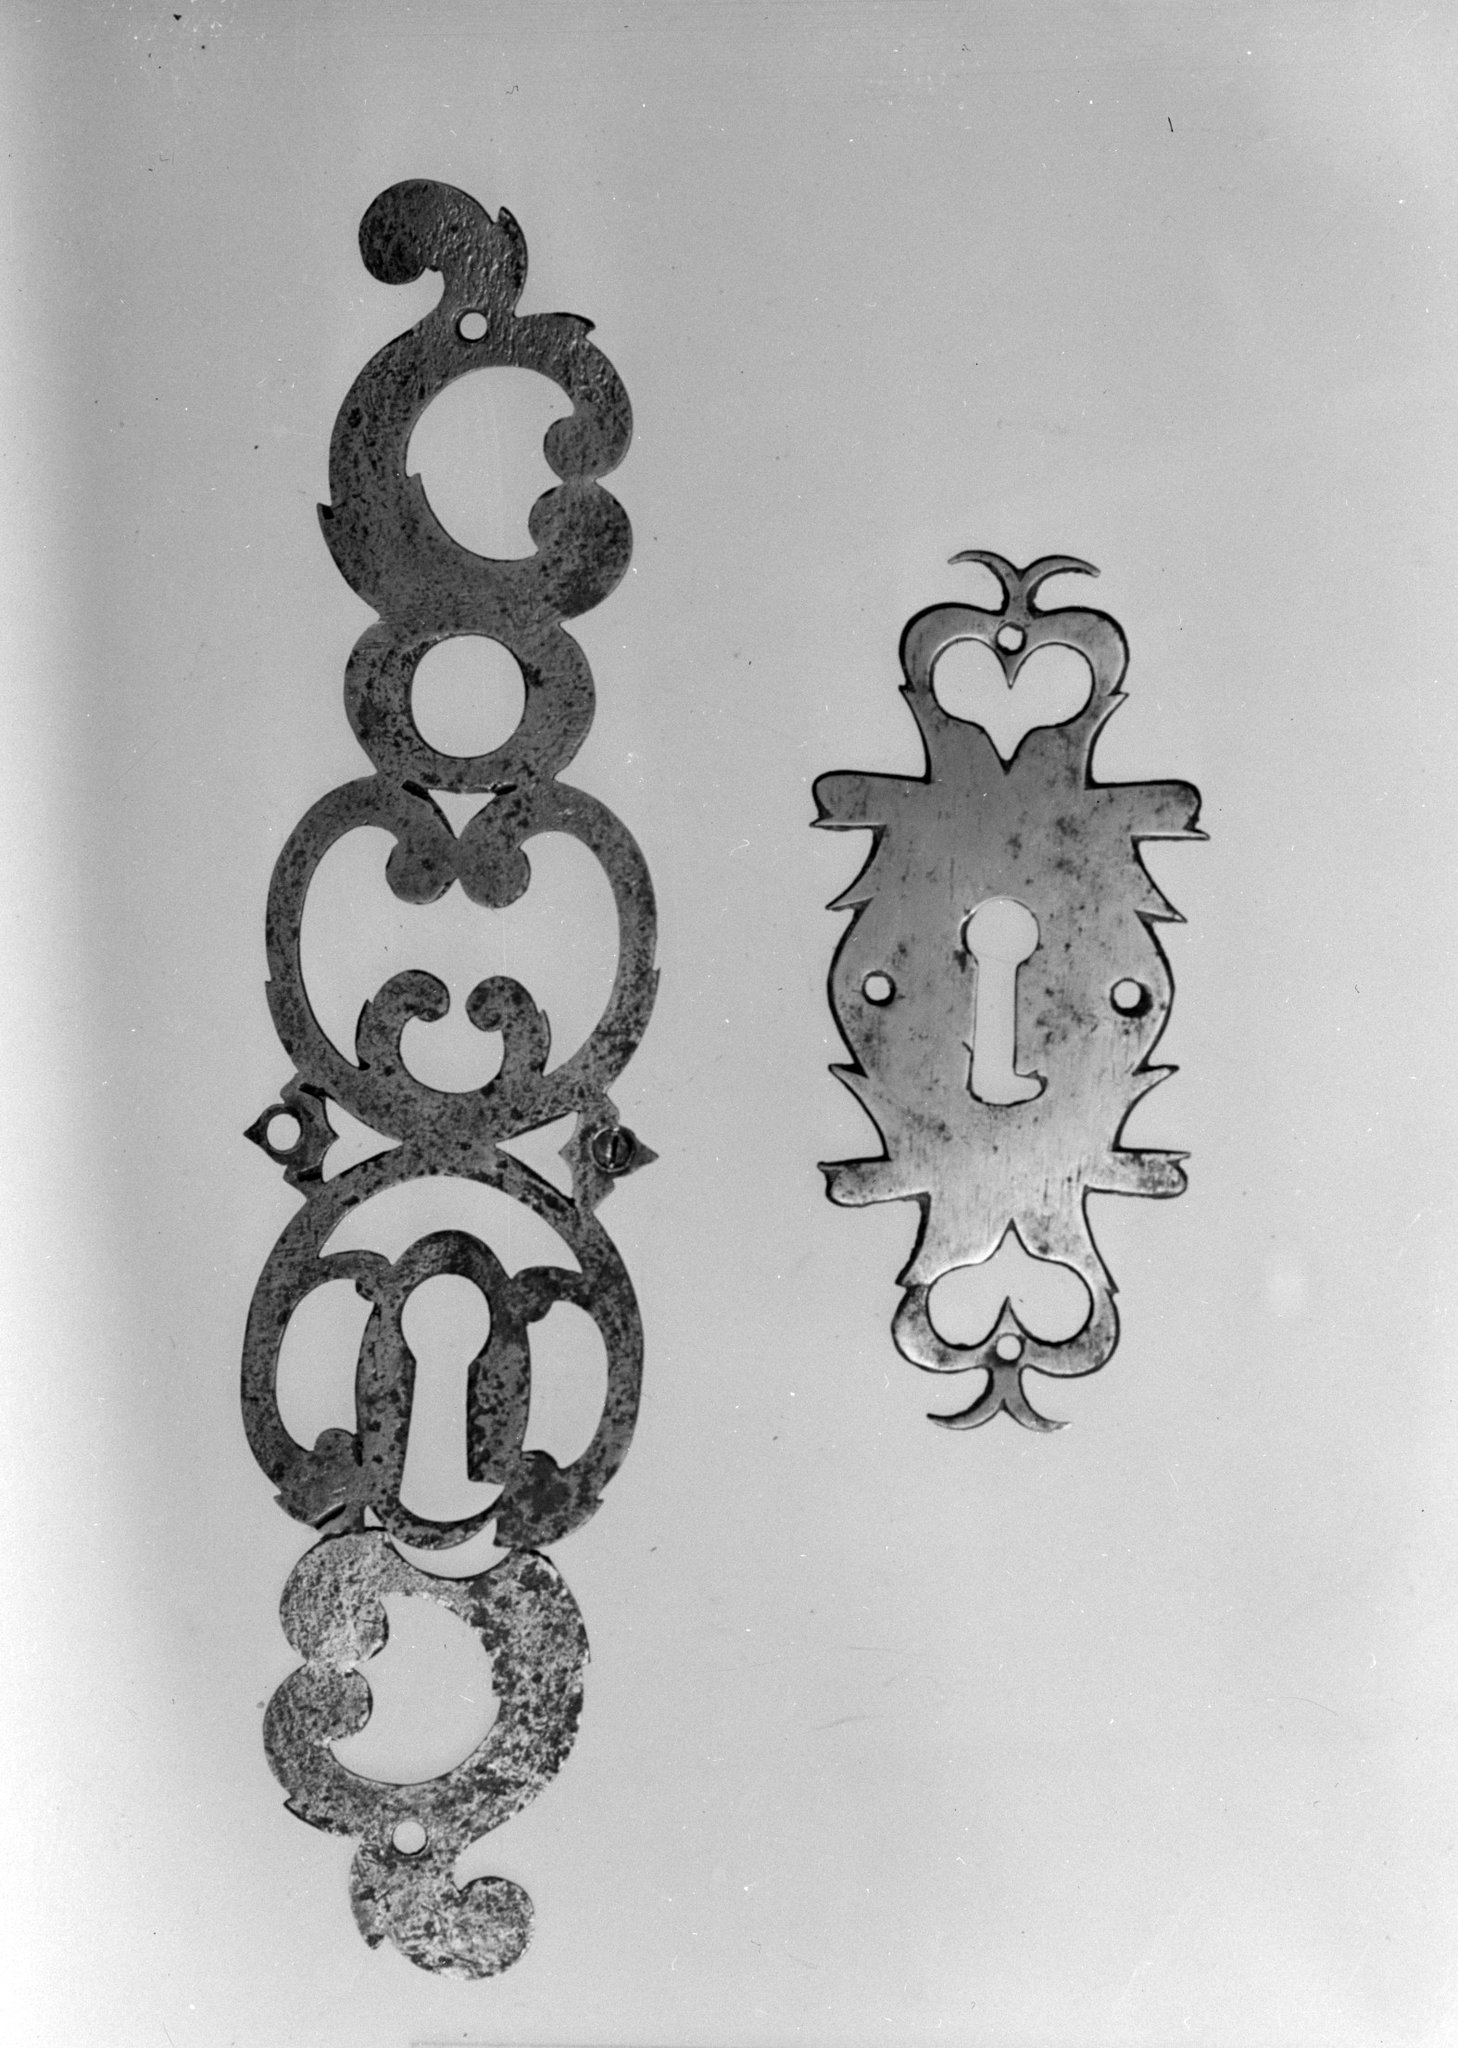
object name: escutcheon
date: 1700-1800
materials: iron